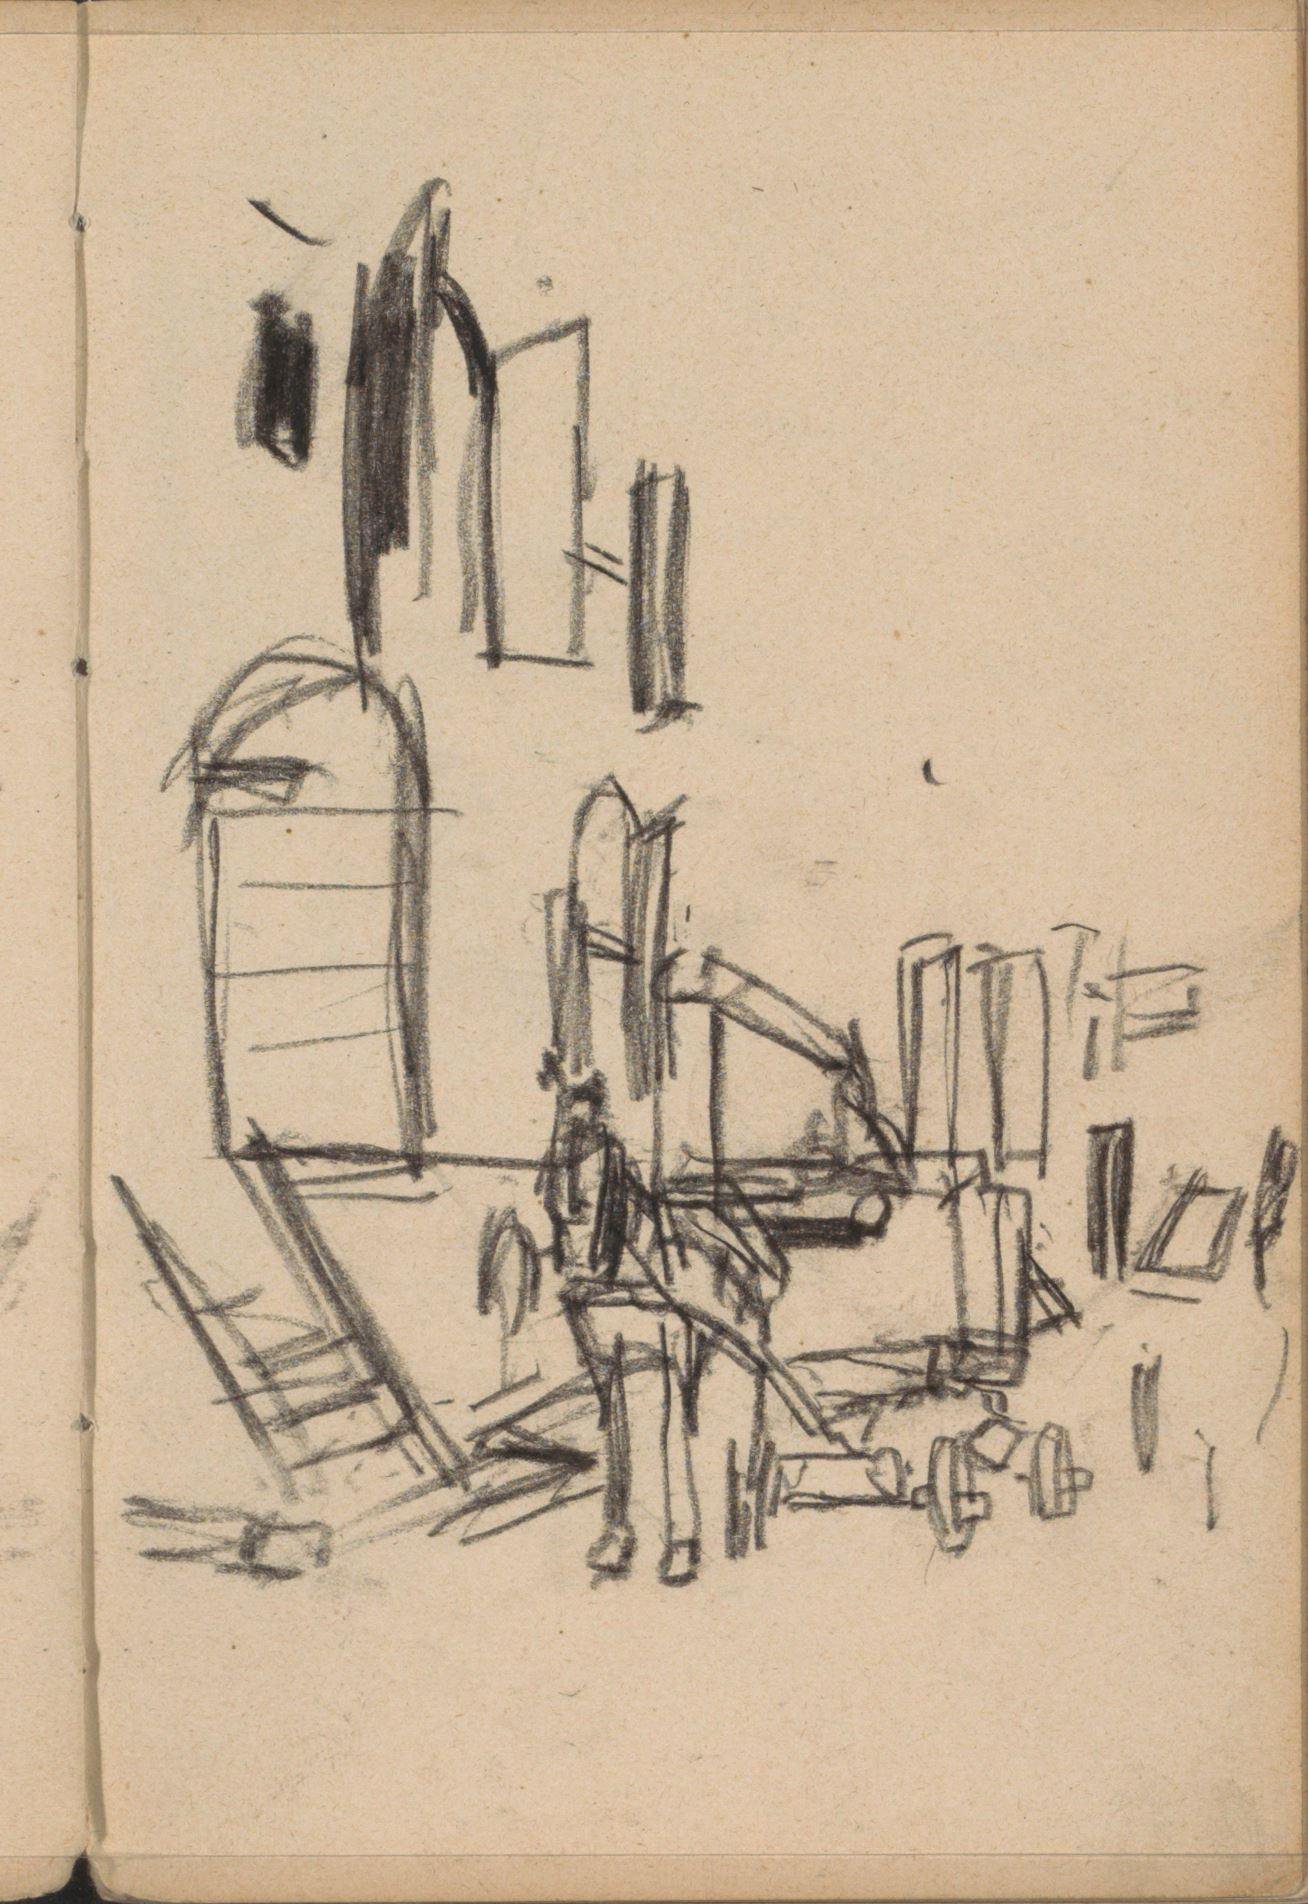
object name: sketchbook leaf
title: Paard-en-wagen voor pakhuizen op Prinseneiland te Amsterdam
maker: george hendrik breitner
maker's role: draughtsman, painter, print maker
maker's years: 1857-1923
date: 1906-1923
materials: chalk, paper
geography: amsterdam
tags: large-scale structure for storage, e.g.: warehouse, depot, silo, four-wheeled vehicle drawn by one animal, horse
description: Paard-en-wagen voor pakhuizen op Prinseneiland te Amsterdam. Pagina 20 uit een schetsboek met 46 bladen vervaardigd in Amsterdam en Haarlem.